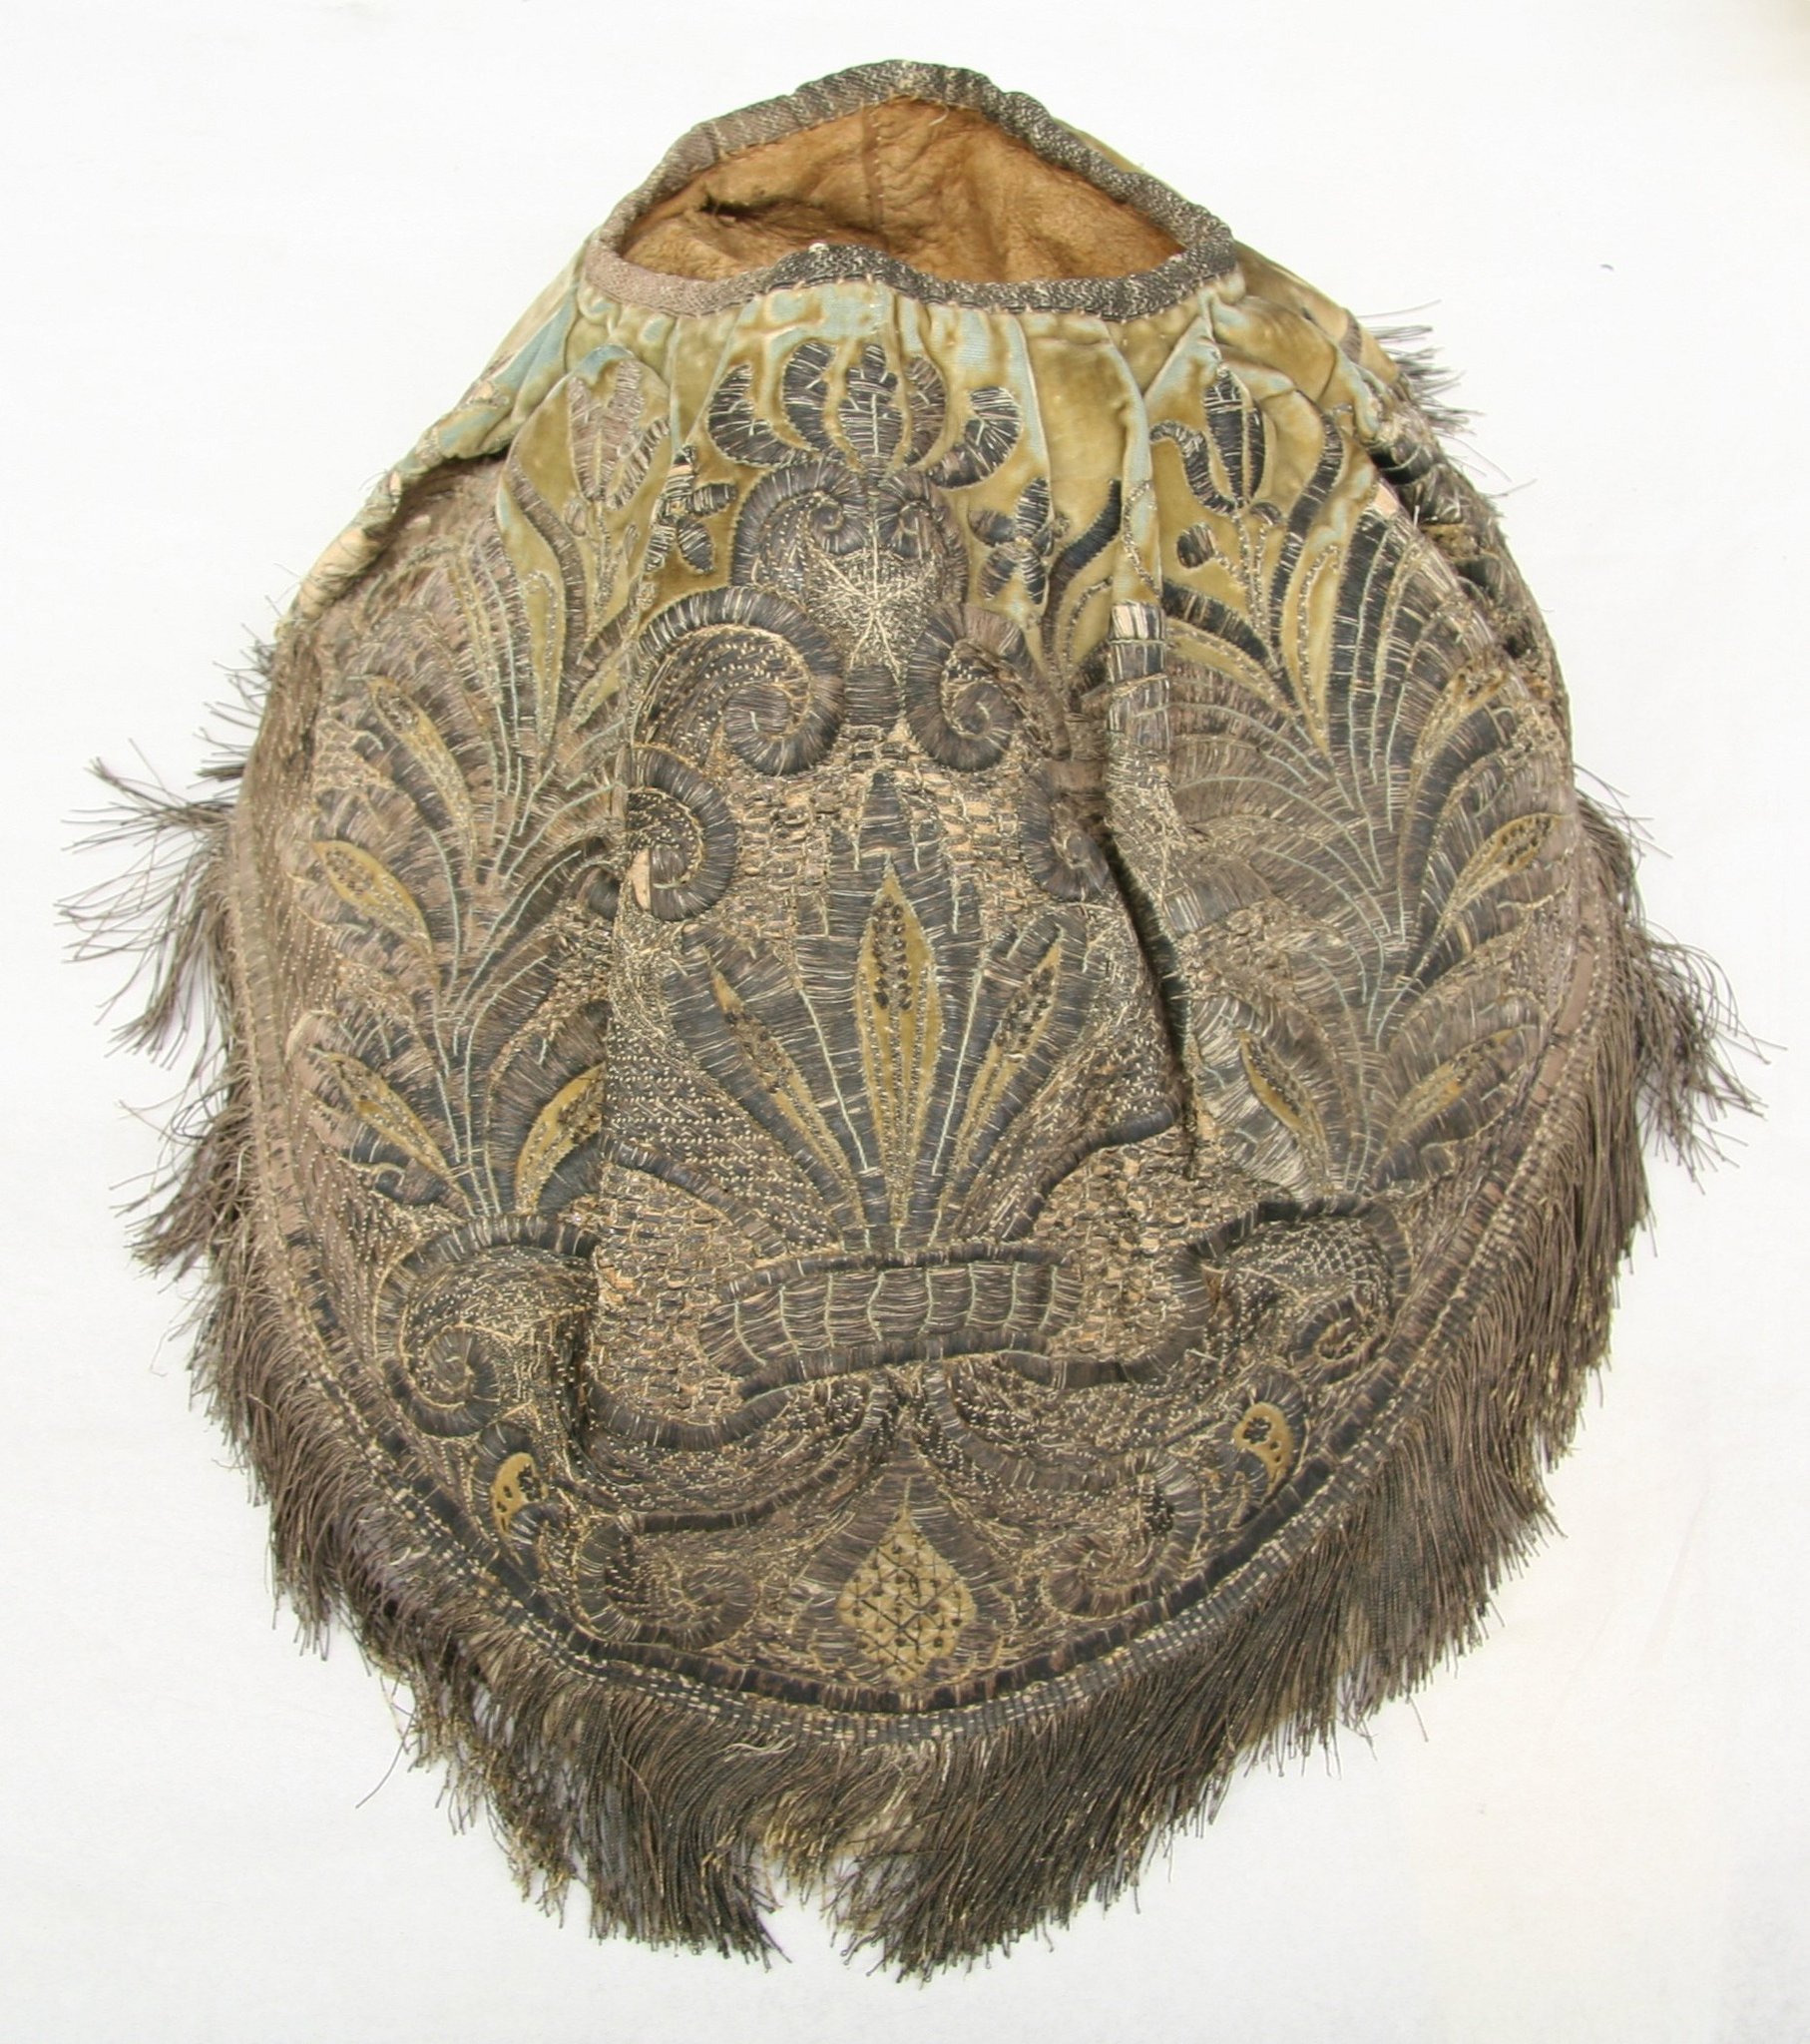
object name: wheellock pistol with holster and horse trapping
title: Wheellock Pistols with Holsters and Horse Trappings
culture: german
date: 1601-1700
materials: bone, metal thread, mother of pearl, textile, wood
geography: germany